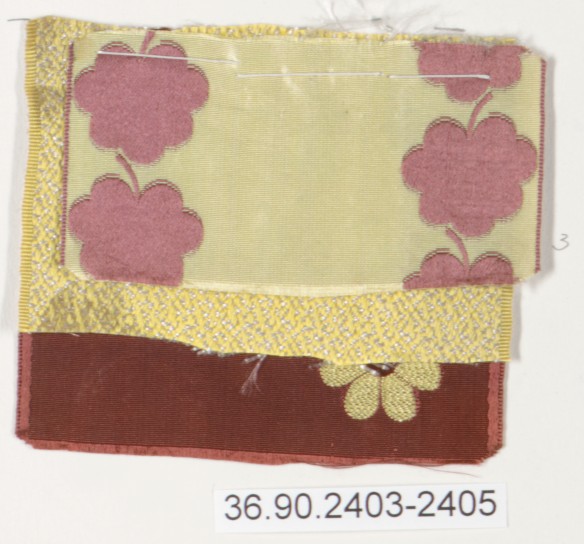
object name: ribbon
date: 1801-1900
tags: flowers